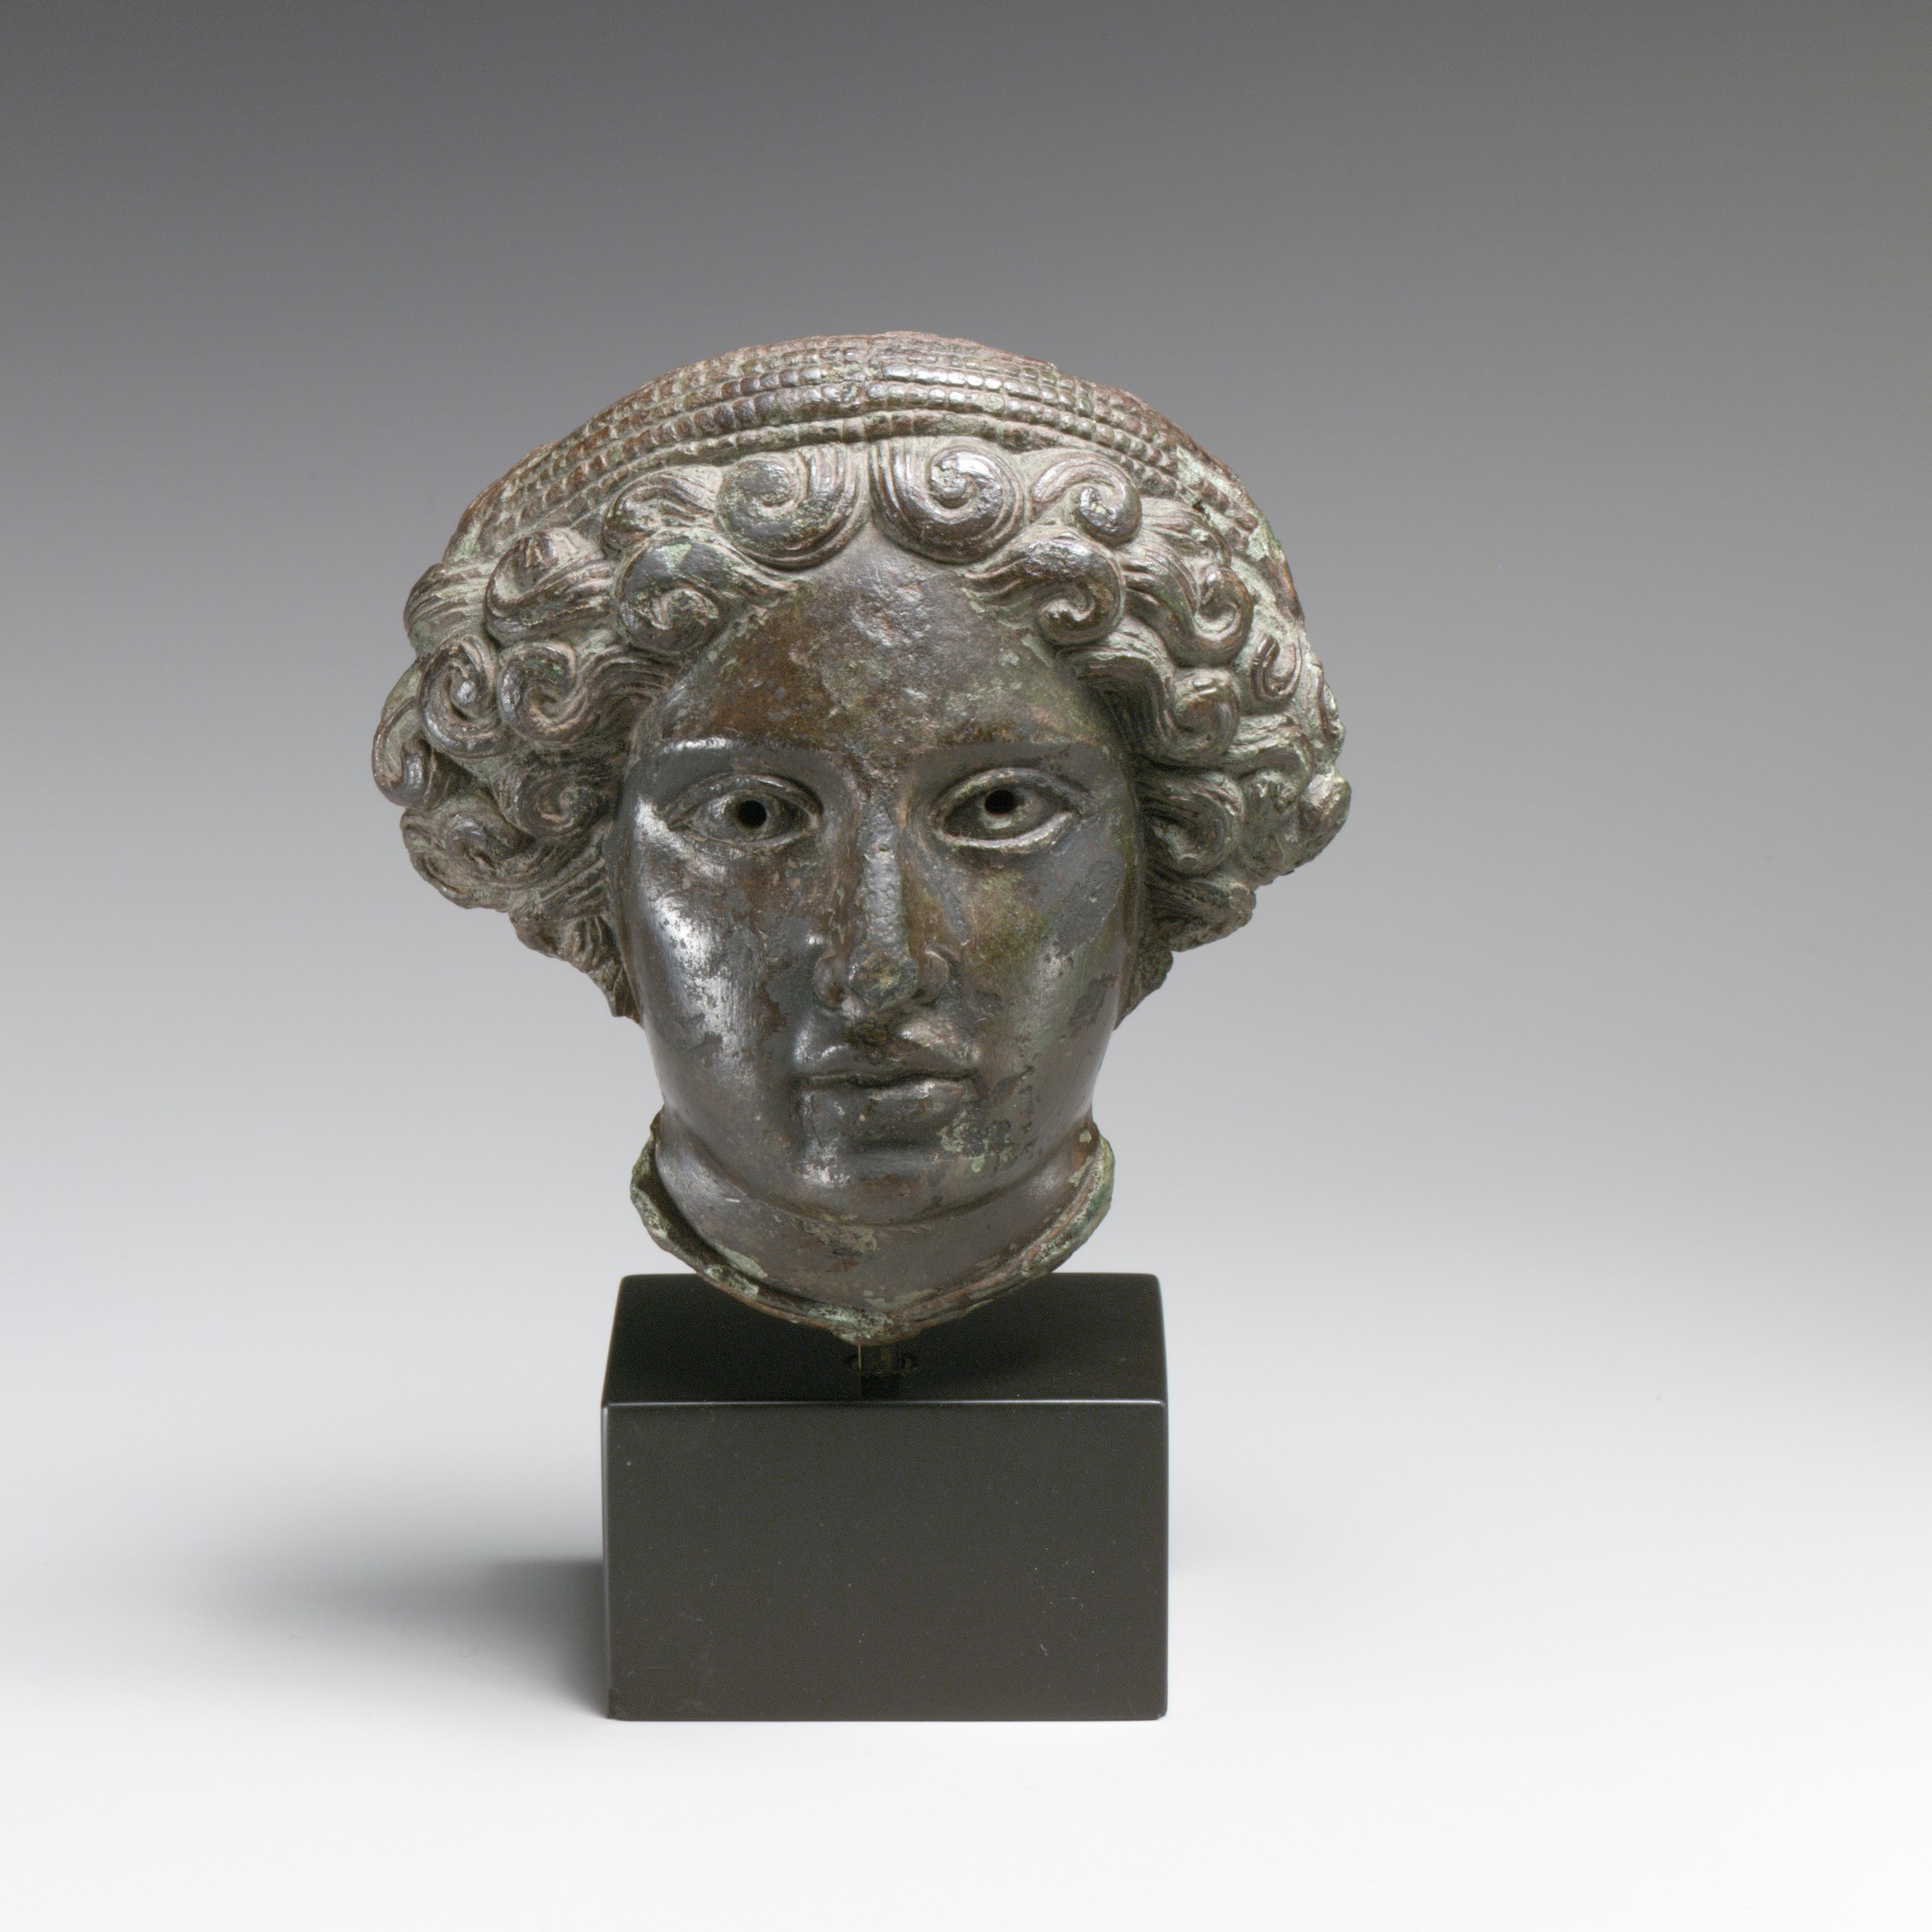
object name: relief of a head of woman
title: Bronze relief of the head of a woman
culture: greek or roman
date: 100-201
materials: bronze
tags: heads,women